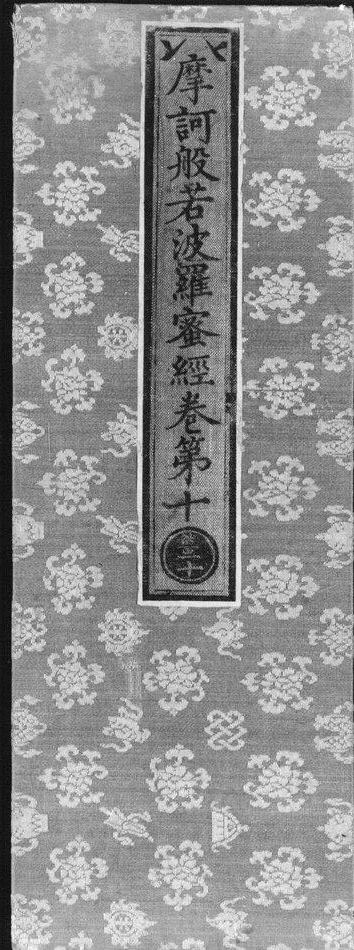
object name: sutra cover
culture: chinese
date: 1601-1700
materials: silk